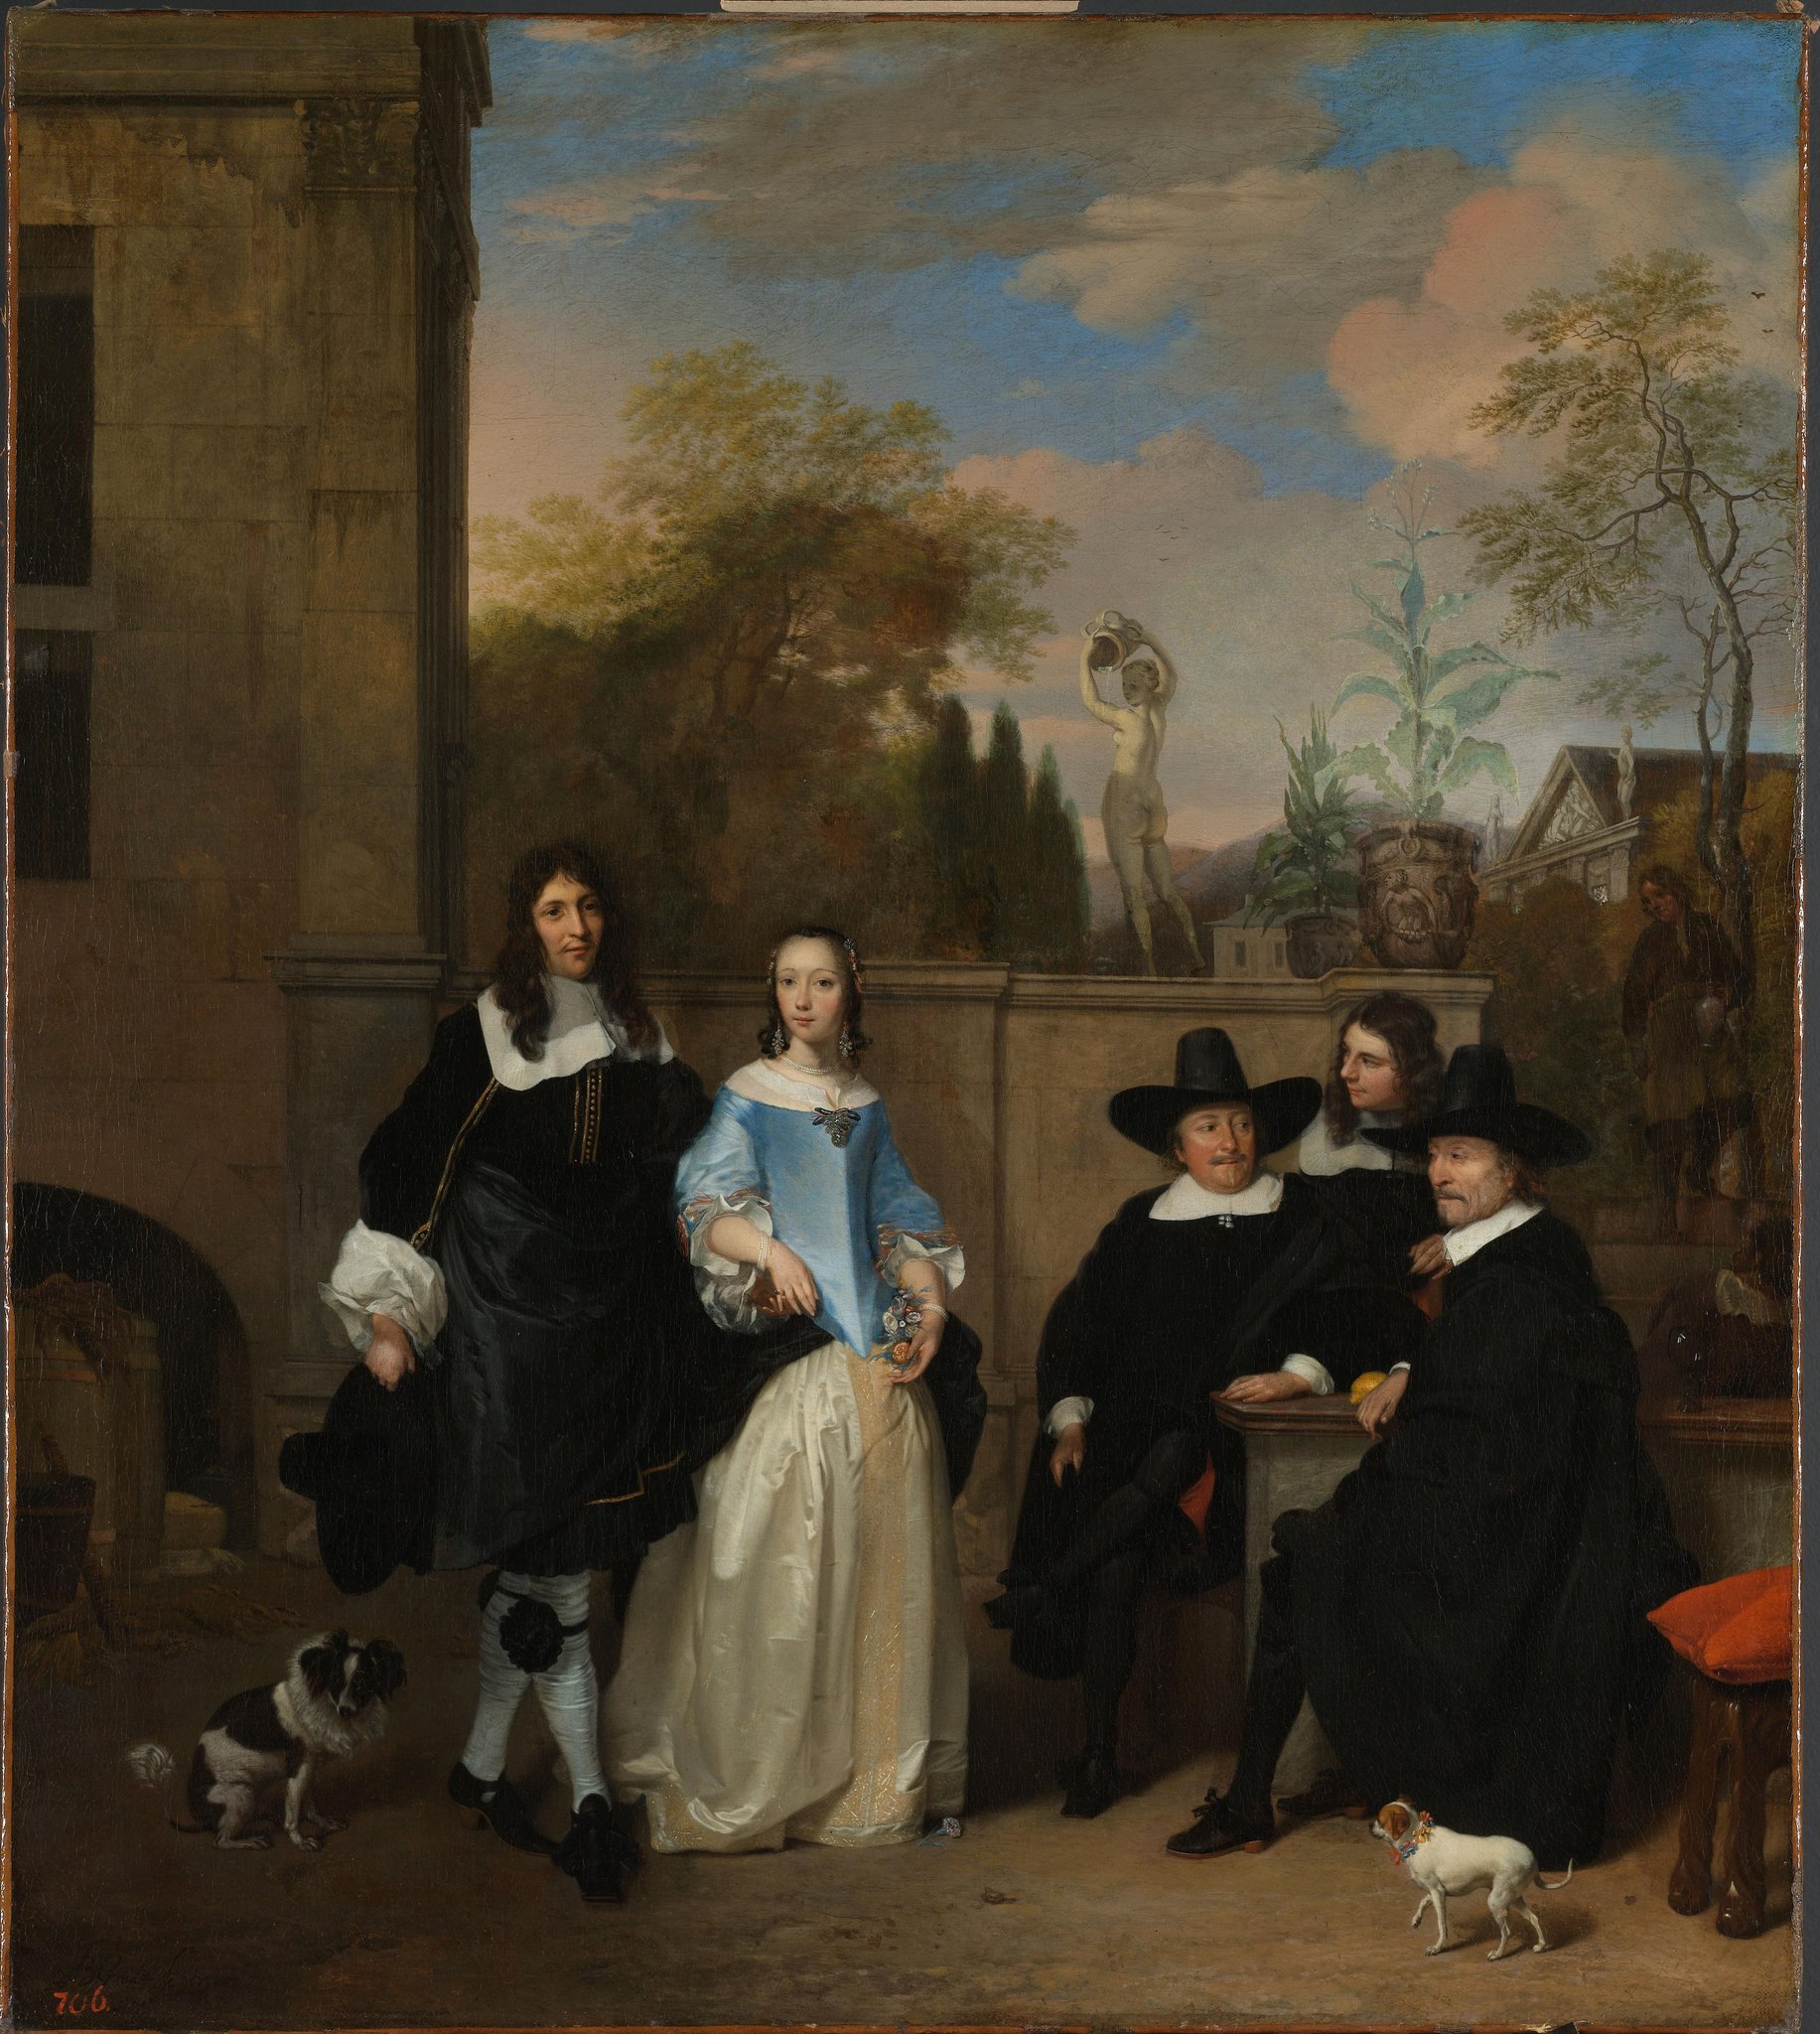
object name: painting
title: Company in a Garden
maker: barend graat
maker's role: draughtsman, print maker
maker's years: 1628-1709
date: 1661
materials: canvas, oil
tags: anonymous historical persons portrayed in a double portrait - bb - woman, anonymous historical persons portrayed in a double portrait, dog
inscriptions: signature and date: ‘B. Graat f 1661’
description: An elegant young couple set foot in the garden of a grand country house. The stiffly corseted woman is draped in costly jewels, and the man too is sumptuously attired; he sports a fashionable garter on his right leg. The identity of this amorous pair holding hands is not known.